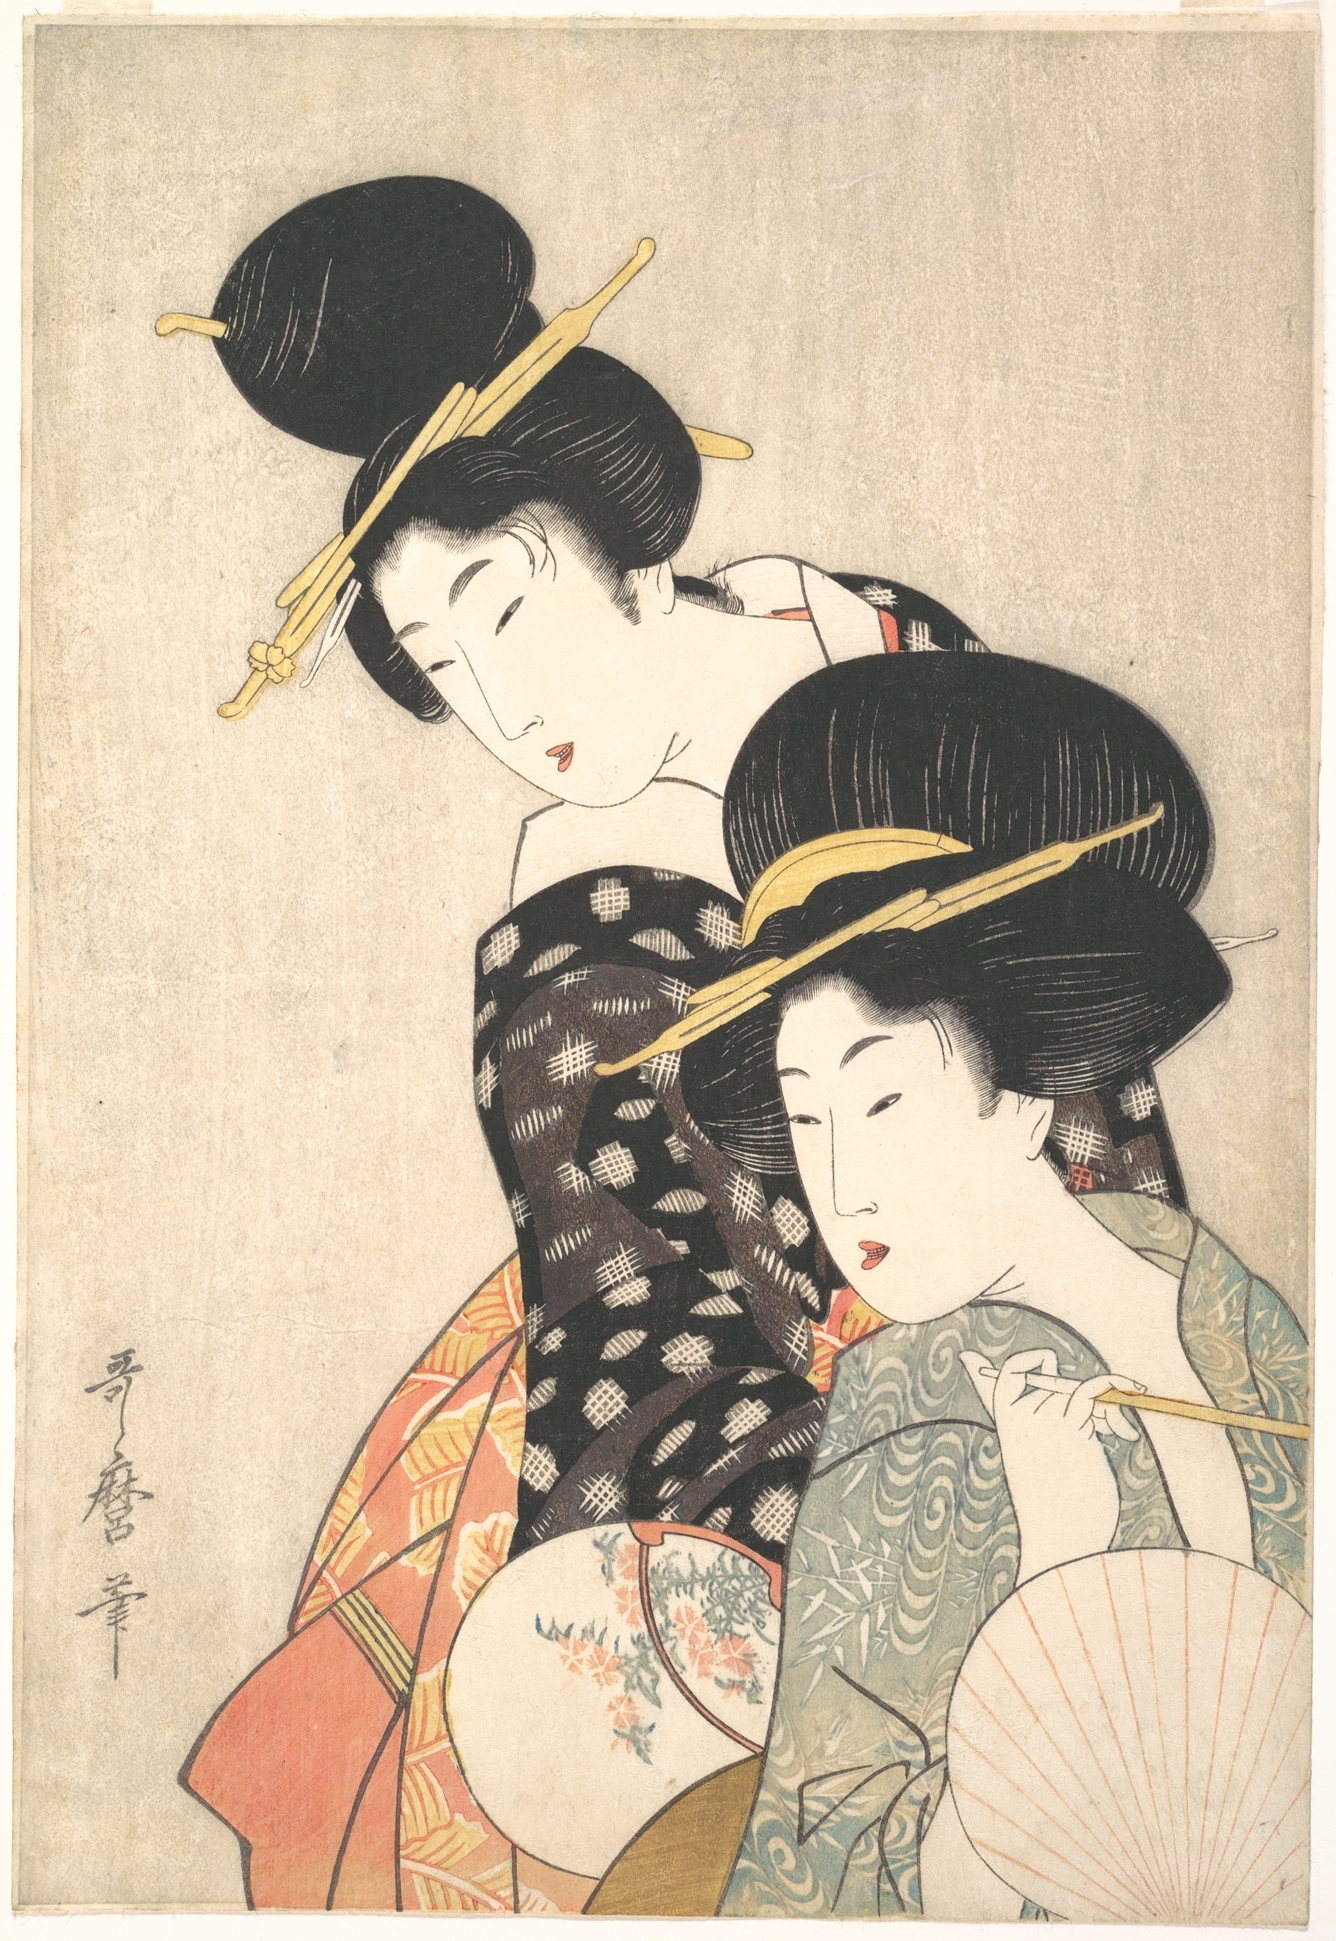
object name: print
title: Two Women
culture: japanese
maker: kitagawa utamaro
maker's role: artist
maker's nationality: japanese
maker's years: 1754-1806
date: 1790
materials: ink, paper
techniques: woodblock print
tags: women